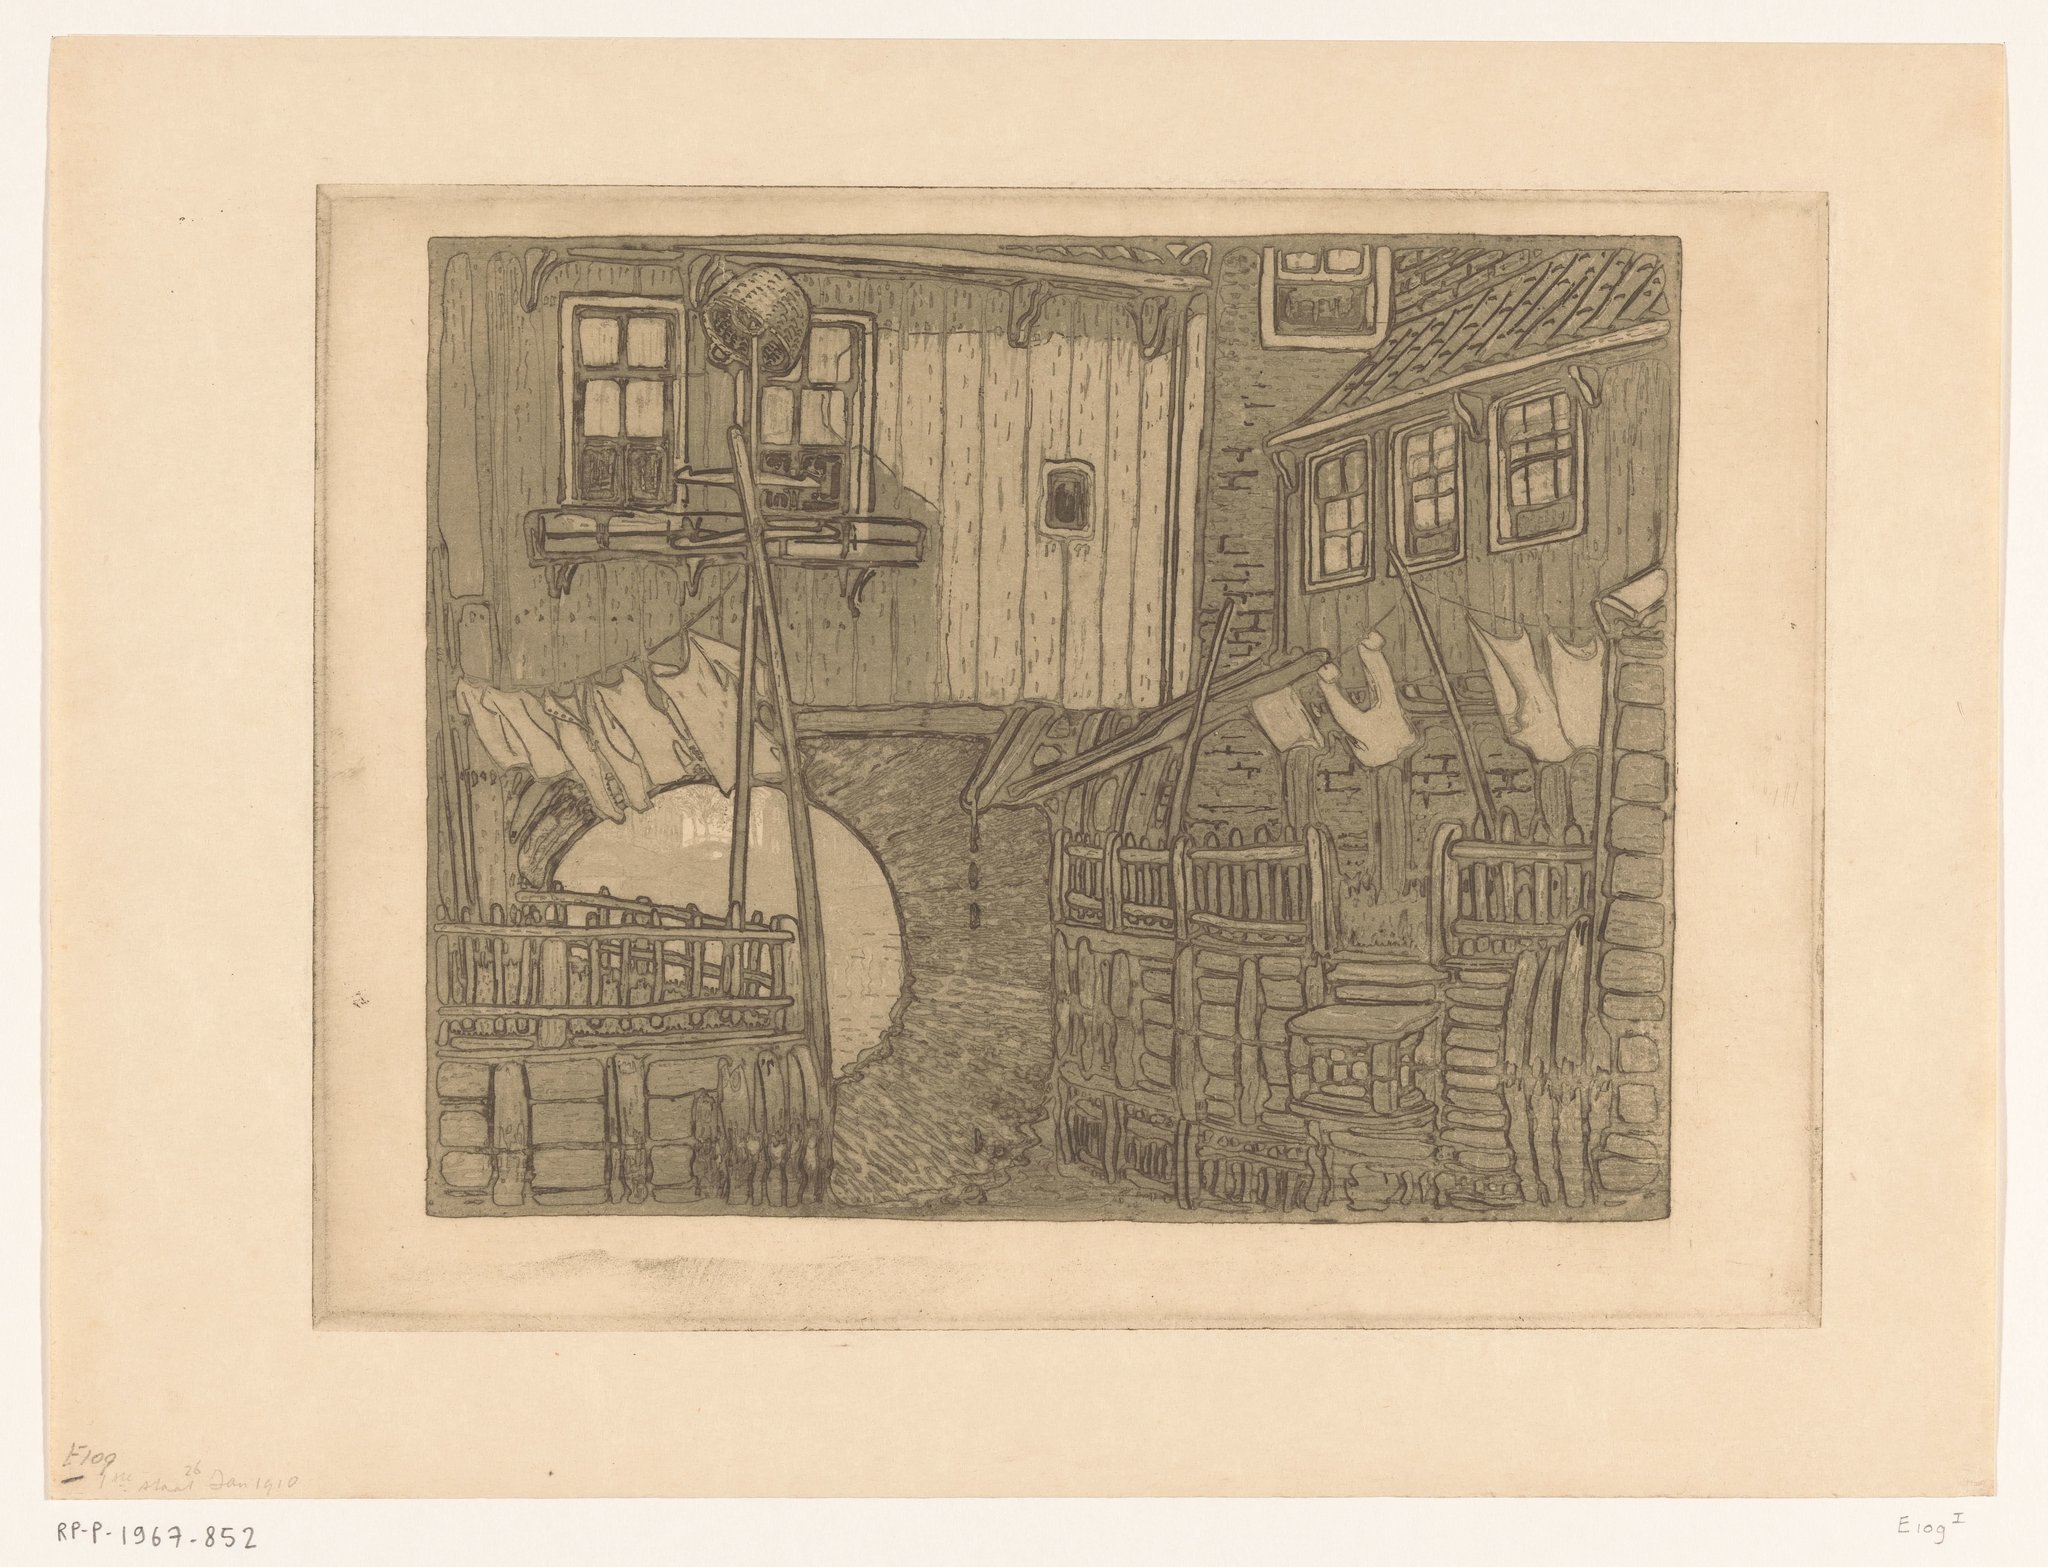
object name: print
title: Buurtje te Enkhuizen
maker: wijnand otto jan nieuwenkamp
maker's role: draughtsman, print maker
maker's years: 1874-1950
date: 1910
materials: paper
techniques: aquatint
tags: canals, waters (in city), hanging the wash to dry, enkhuizen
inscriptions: collector's mark: Lugt 2228, collector's mark: Lugt 2760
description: Op de voorgrond kleding die aan waslijnen hangt te drogen. Links een huis dat over het water heen is gebouwd.